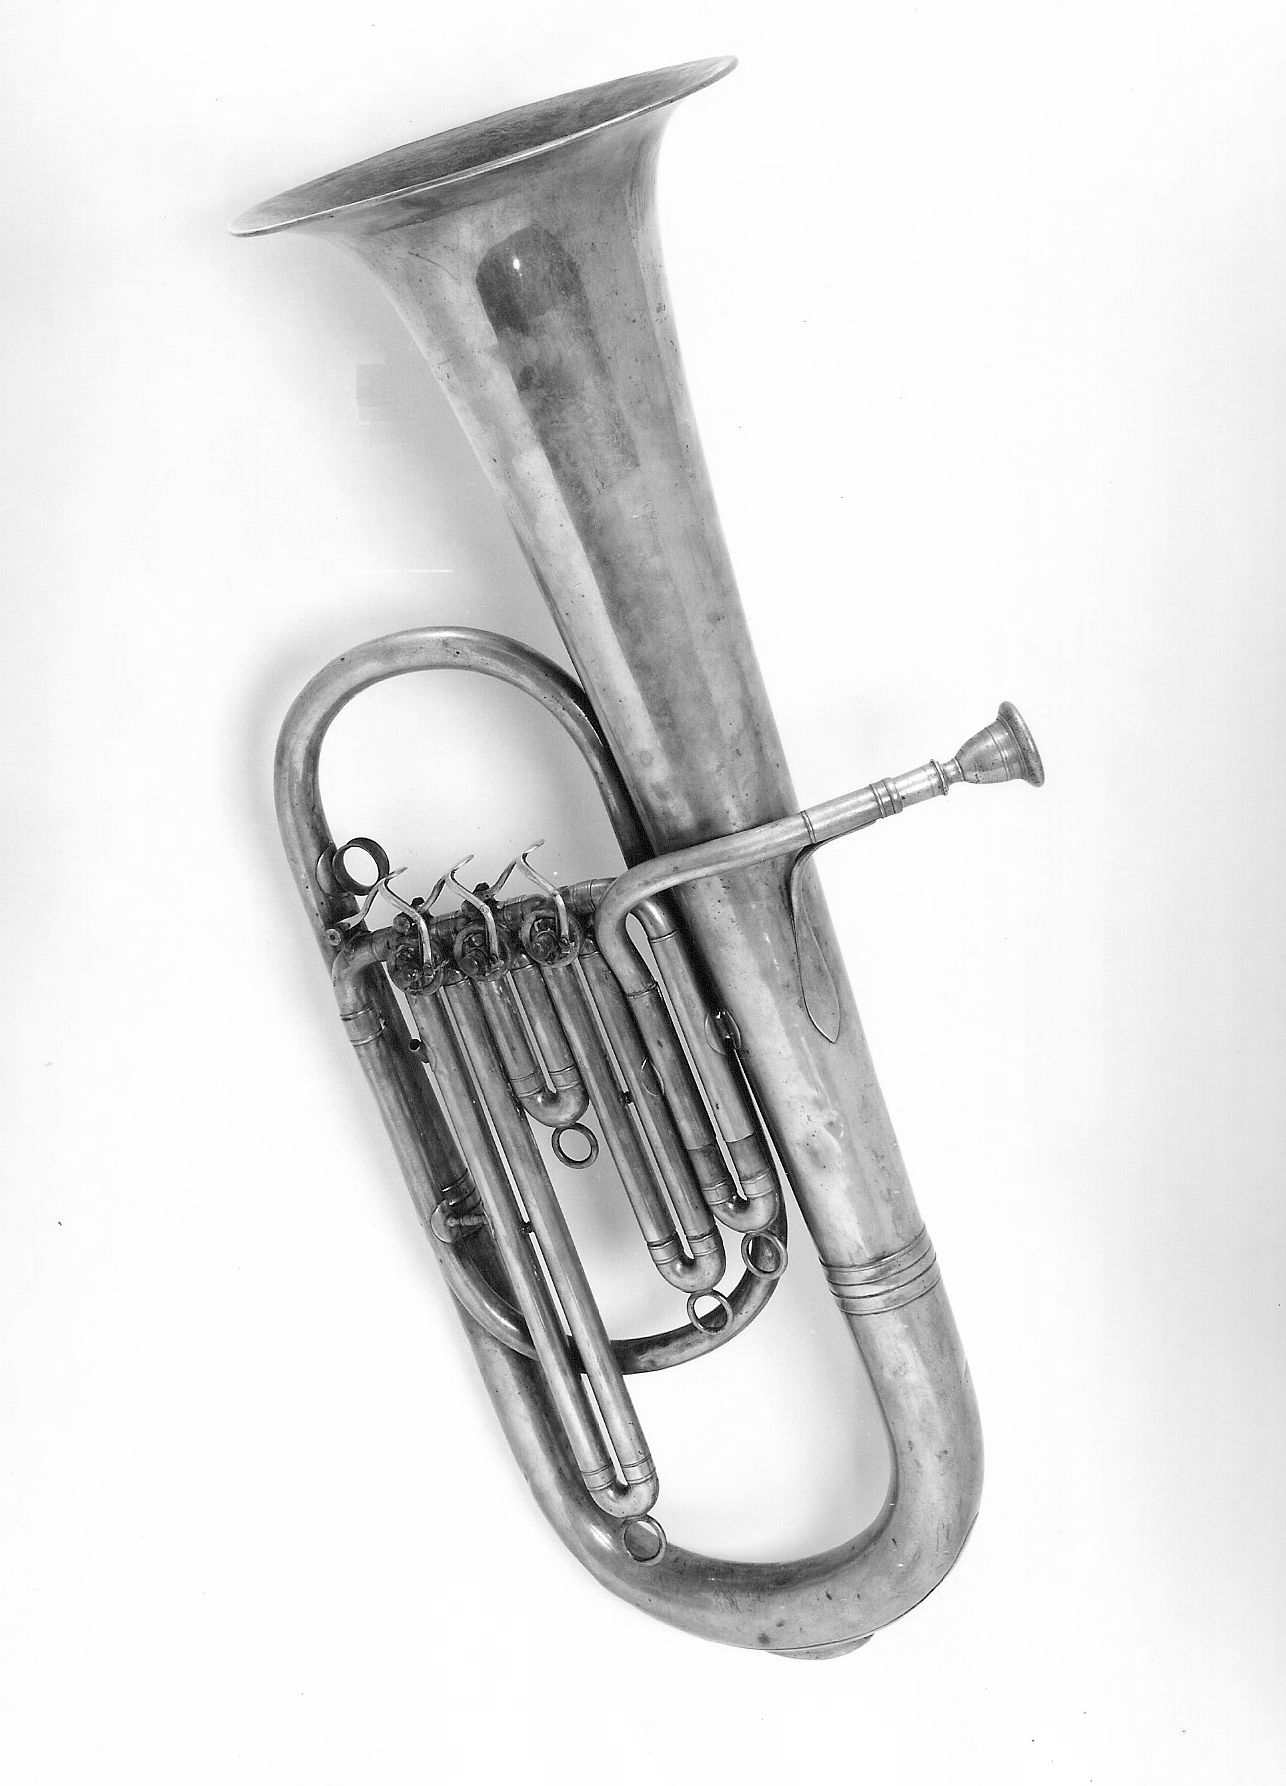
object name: soprano saxhorn in b flat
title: Tenor Saxhorn in B-flat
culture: american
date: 1850-1875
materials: brass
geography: united states